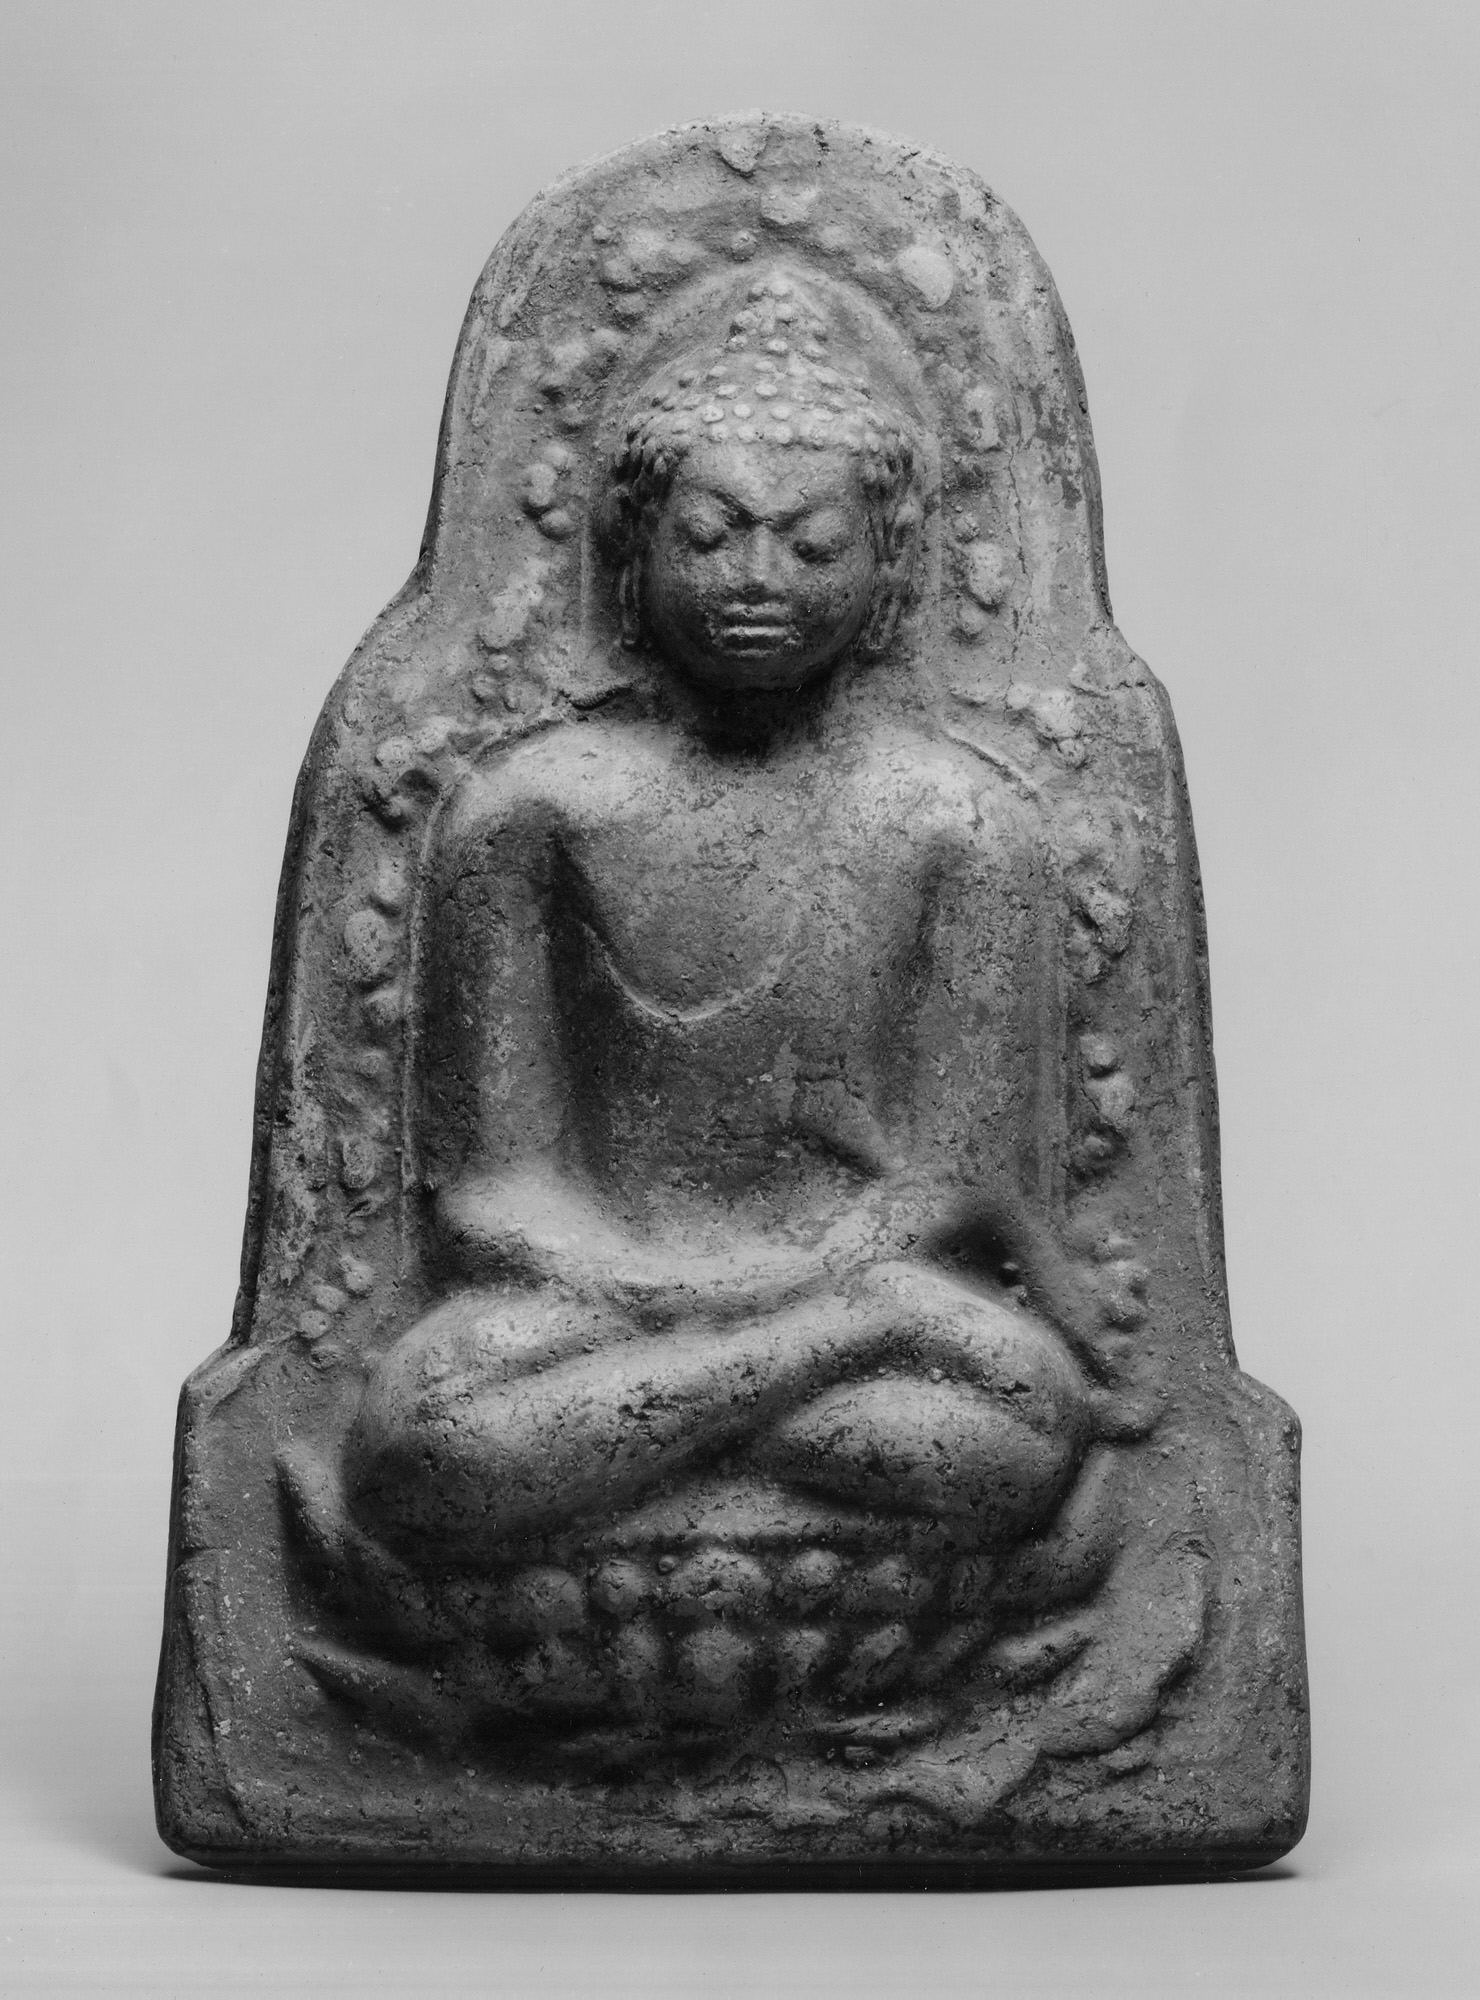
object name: votive plaque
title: Seated Buddha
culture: thai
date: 701-800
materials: terracotta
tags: buddhism,buddha